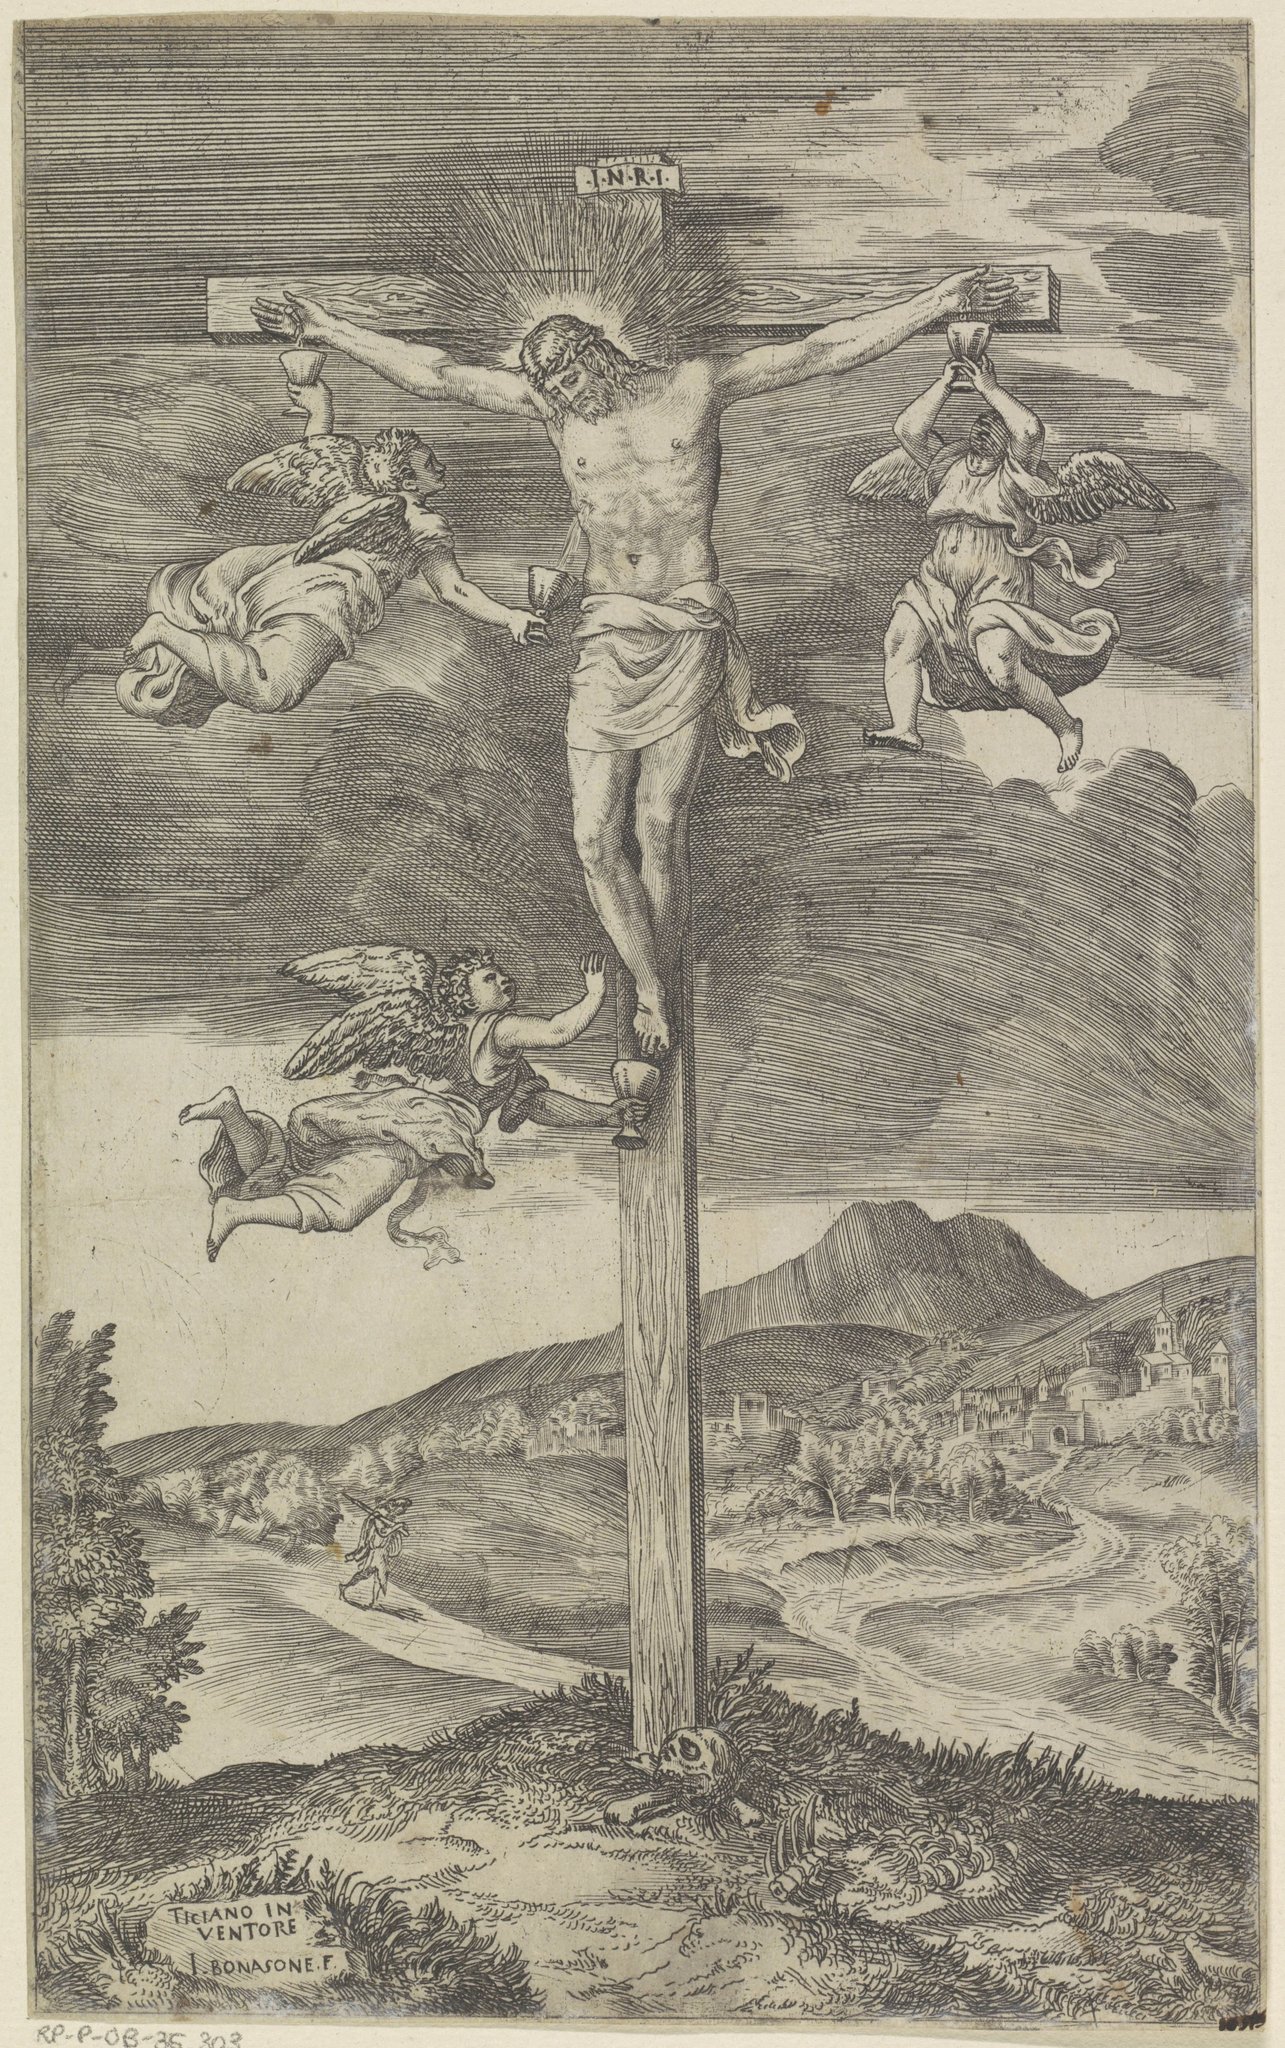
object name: print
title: Gekruisigde Christus met drie engelen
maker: giulio bonasone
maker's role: painter, print maker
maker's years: 1510-1576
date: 1501-1580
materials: paper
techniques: etching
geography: italy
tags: specific types of crucified christ (in non-narrative context) (+ angel(s))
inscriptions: collector's mark: Lugt 240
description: Christus aan het kruis in een landschap. Drie zwevende engelen vangen het bloed van Christus op in bekers.